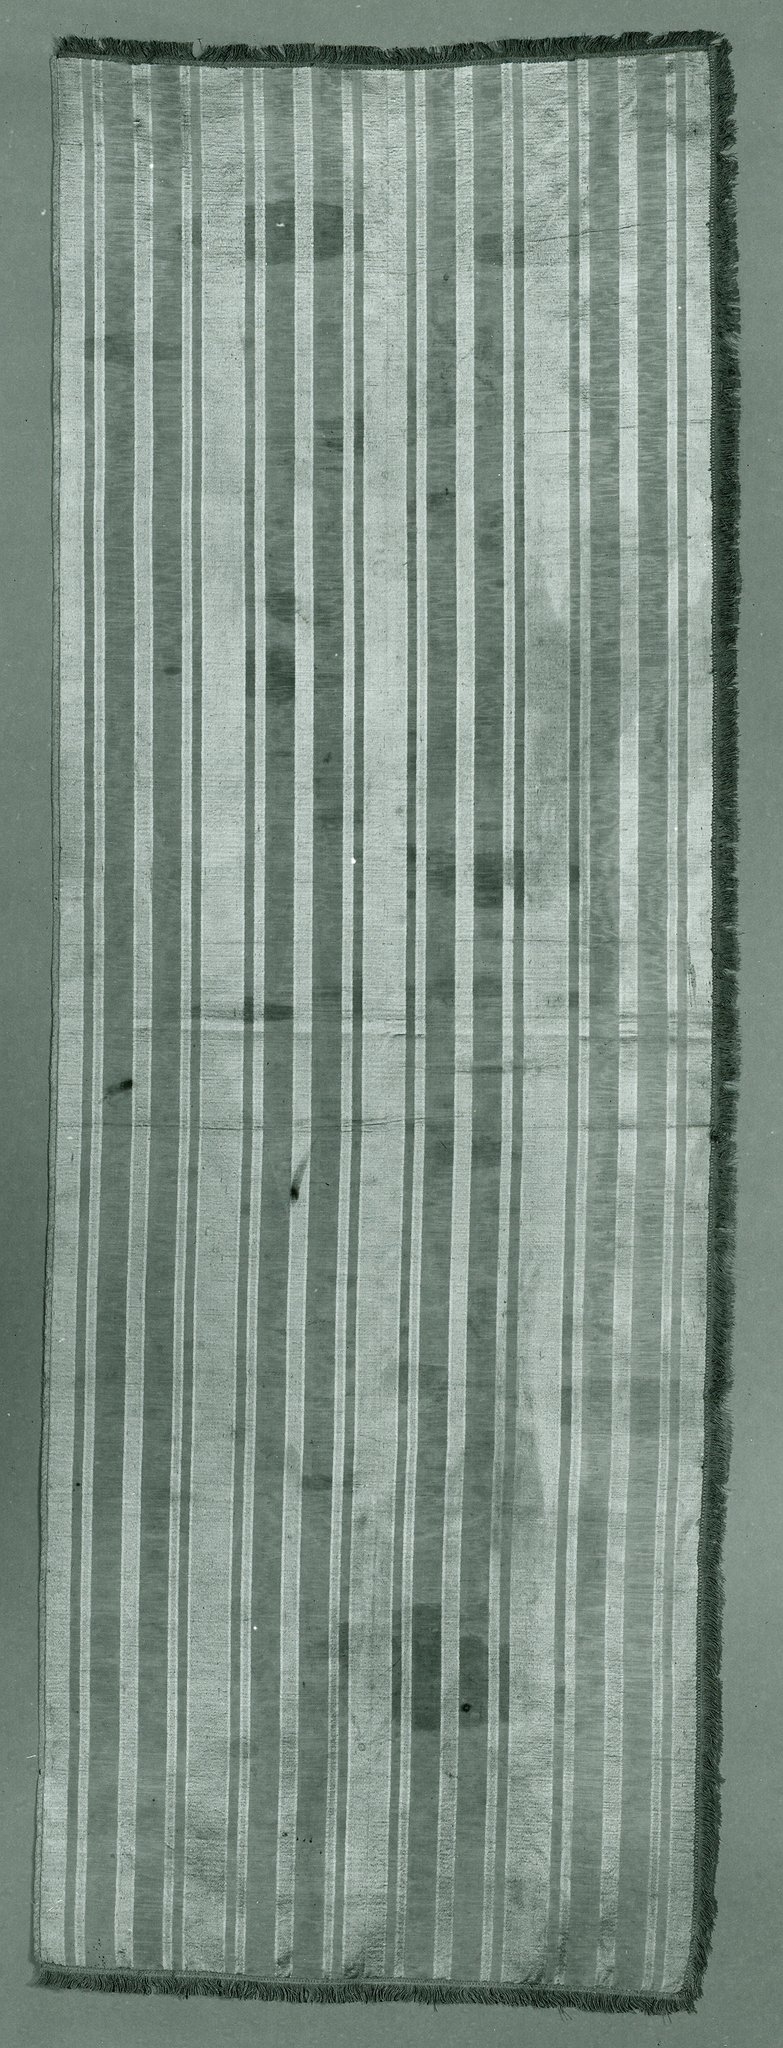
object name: textile panel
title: panel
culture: french or italian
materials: silk